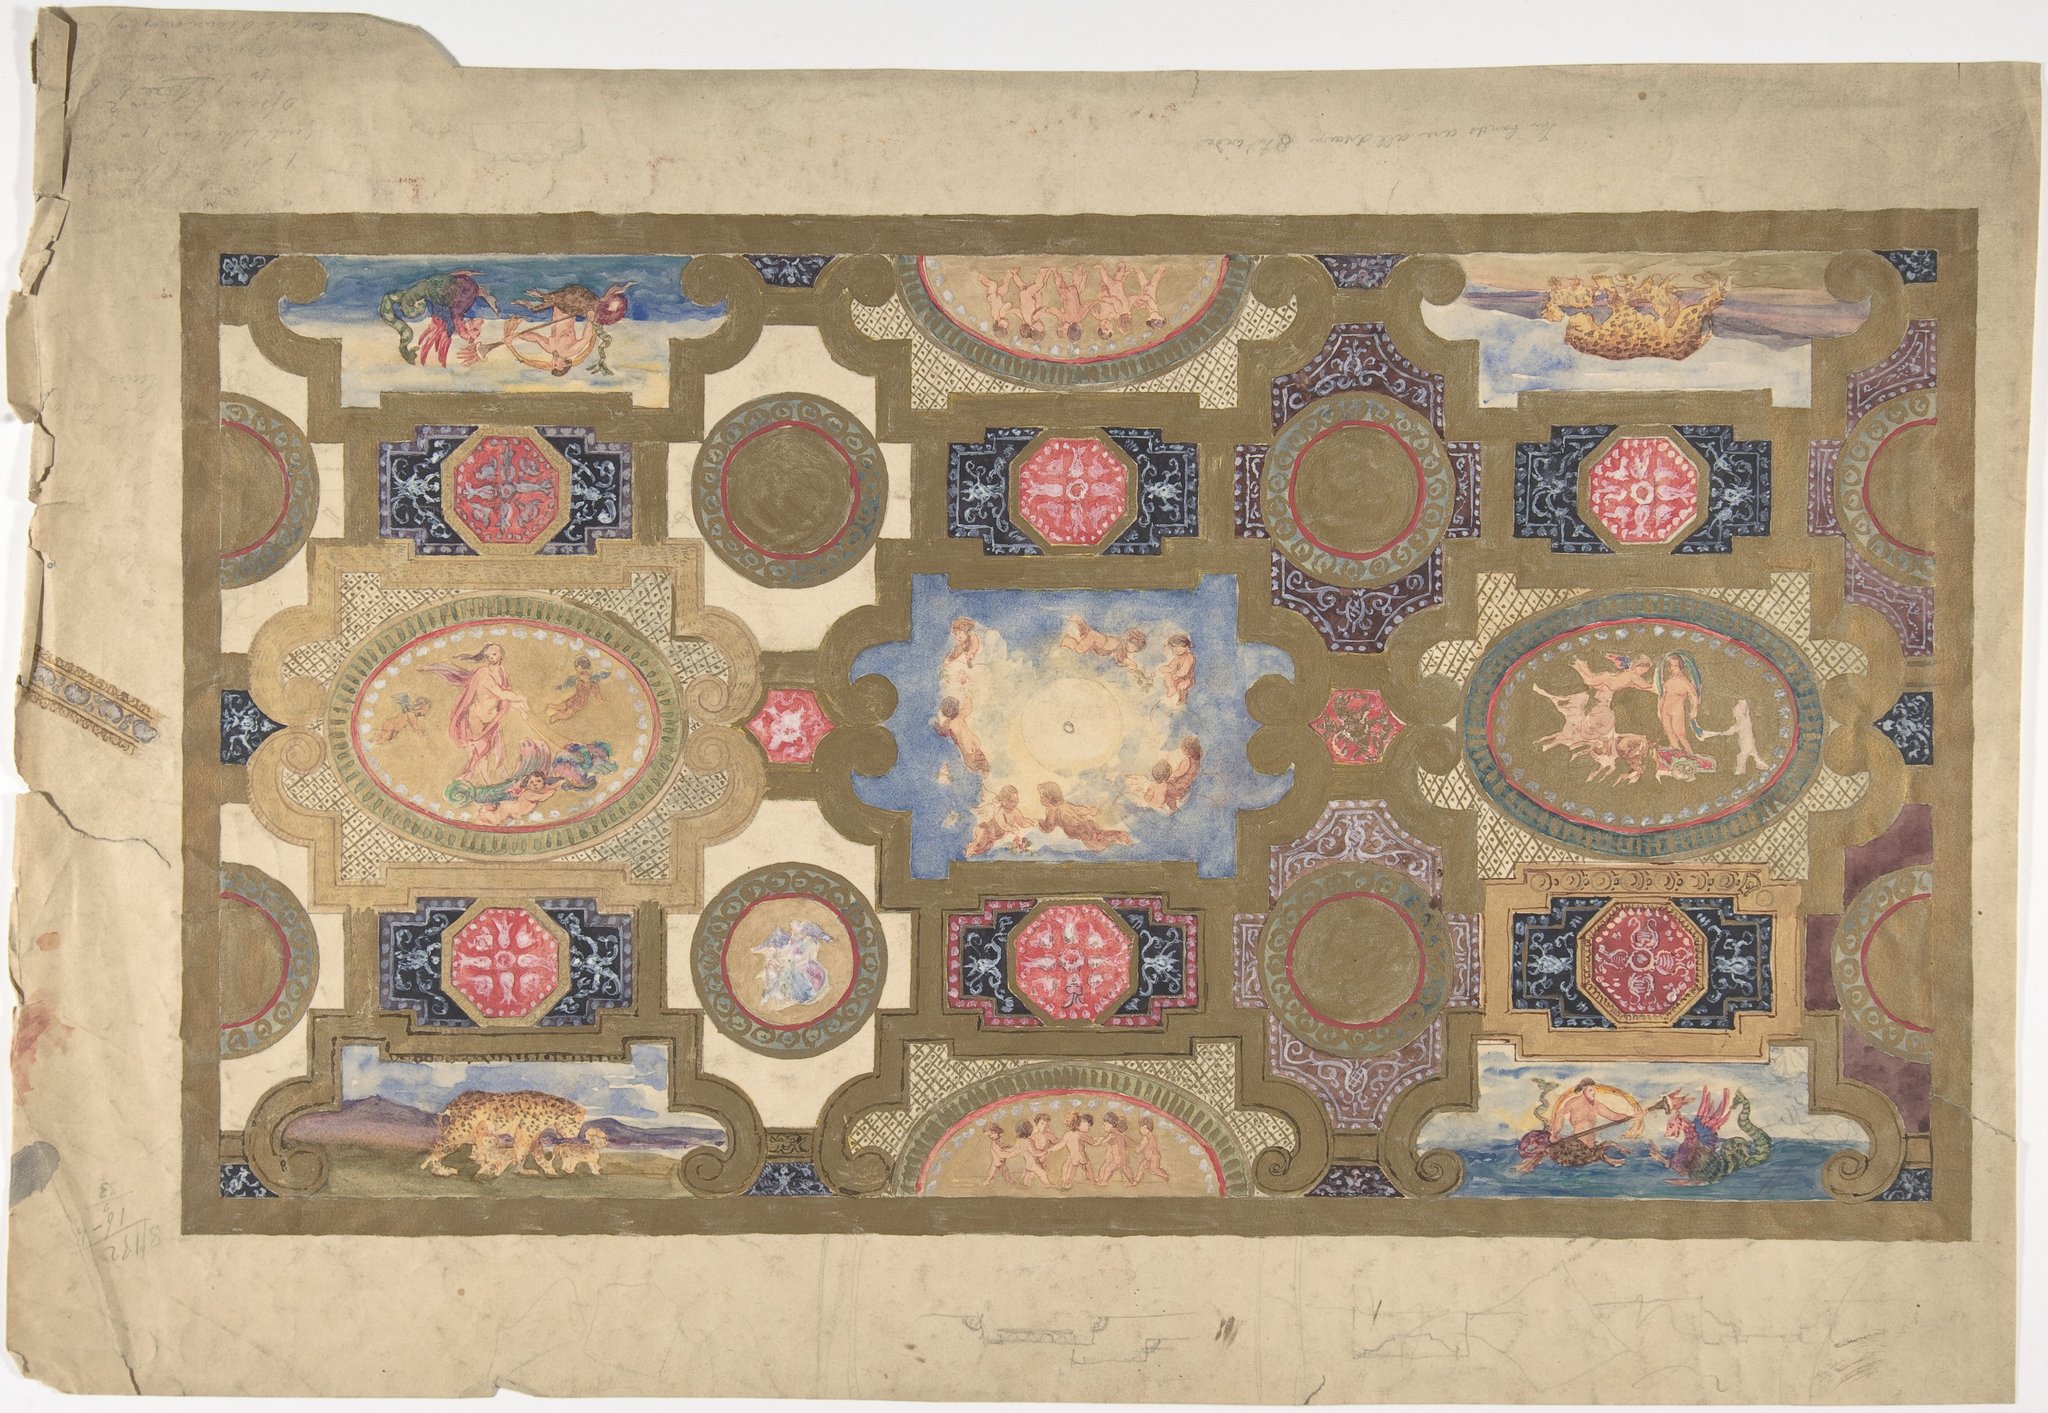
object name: drawing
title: Ceiling Design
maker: anonymous, british, 19th century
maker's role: artist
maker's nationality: british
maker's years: 1800-1900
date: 1801-1900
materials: gold, ink, watercolor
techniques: pen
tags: putti,leopards,ceilings